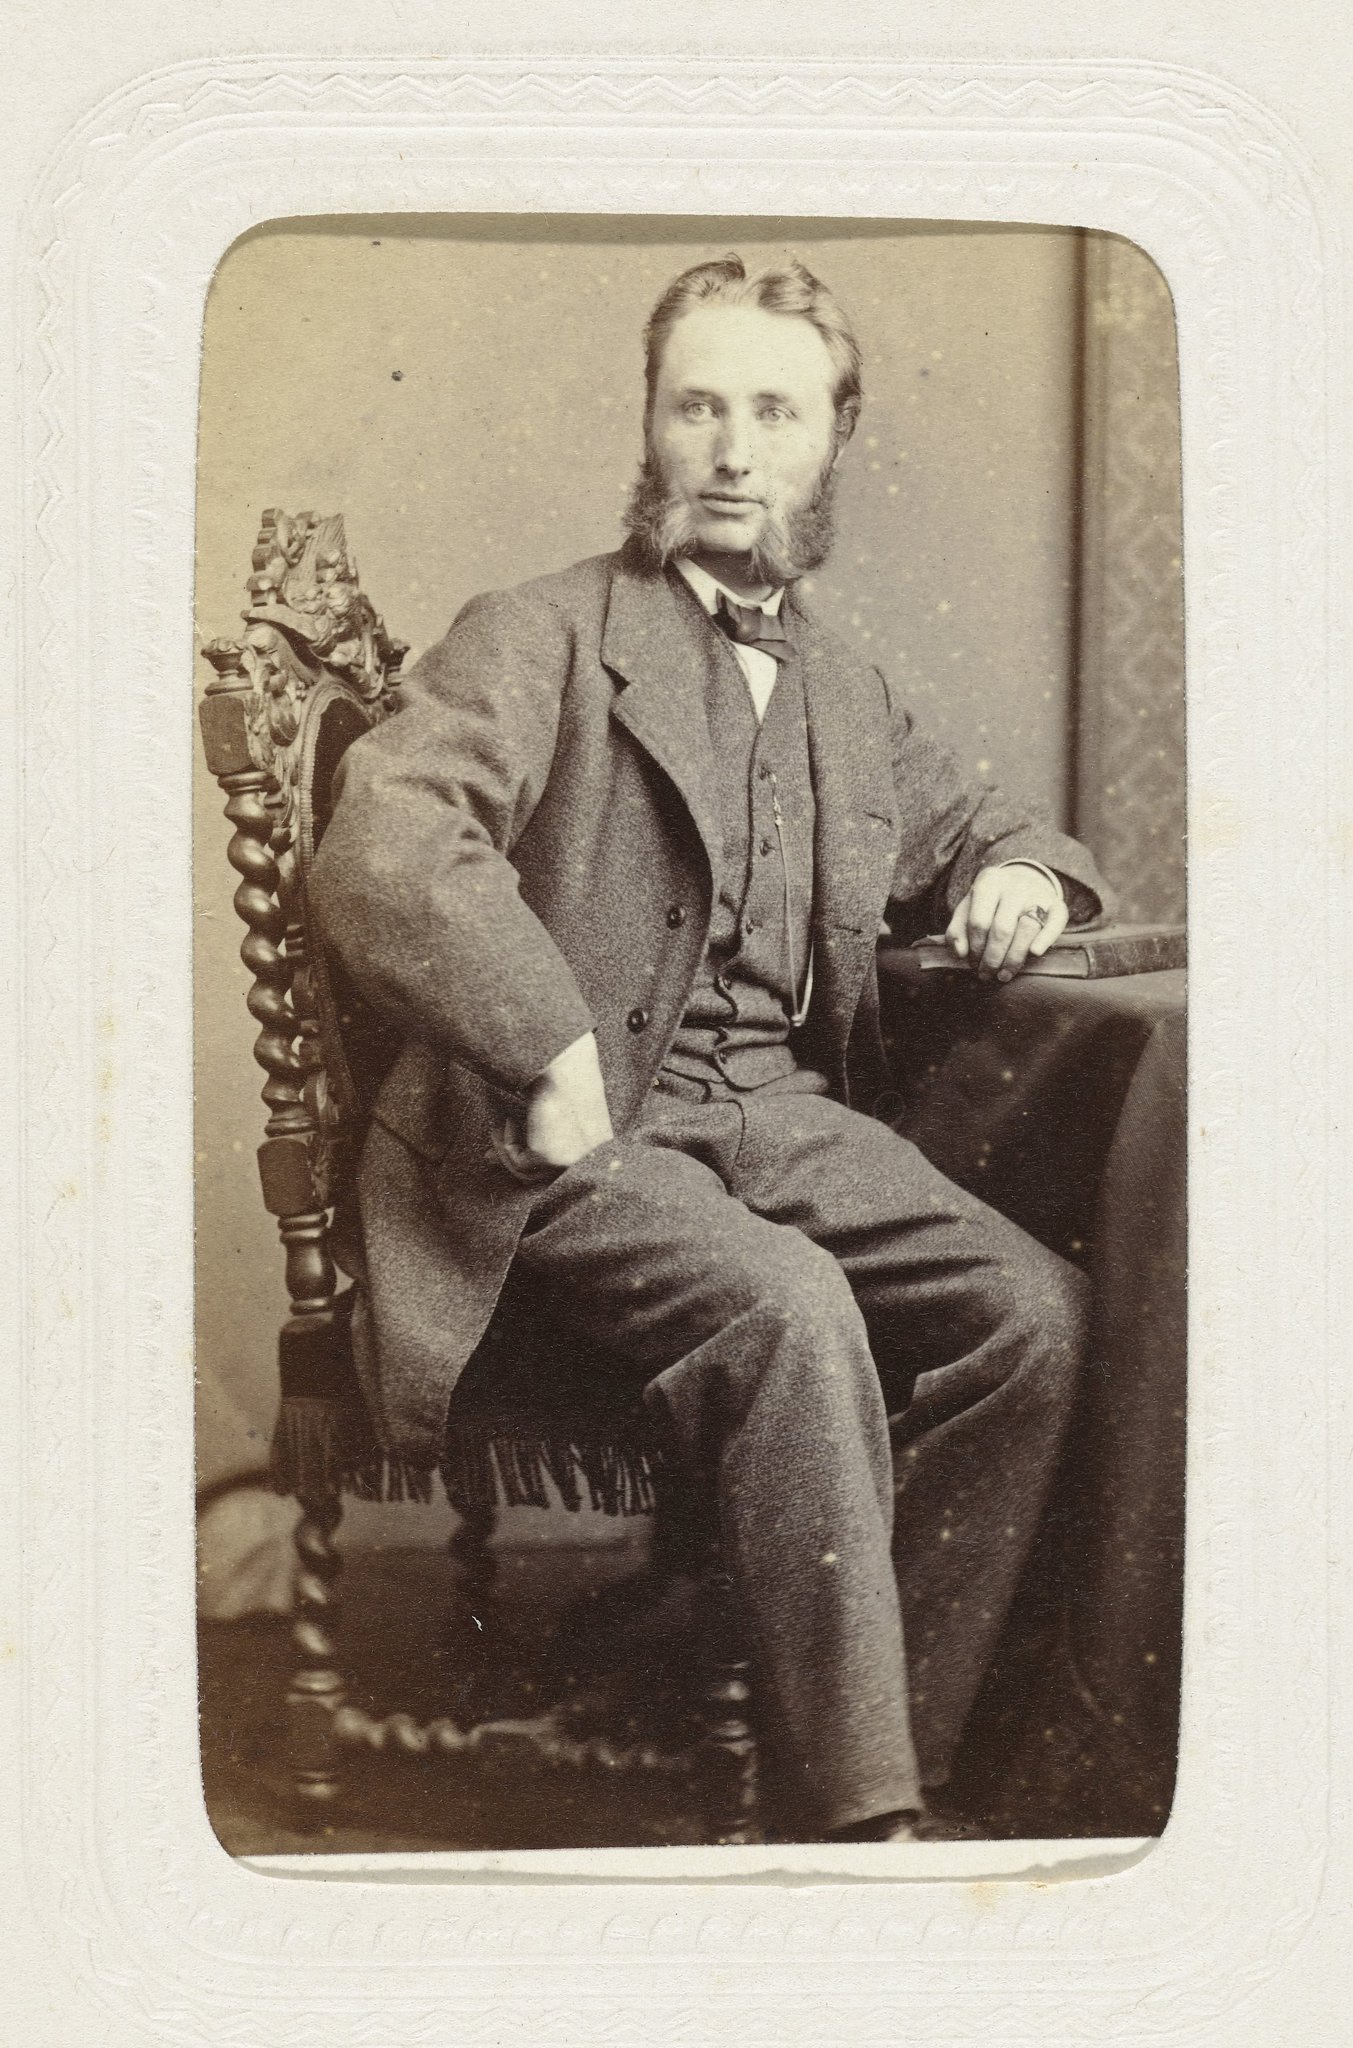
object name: carte de visite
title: Studioportret van een zittende man met grote bakkebaarden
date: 1863-1866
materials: cardboard, paper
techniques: albumen print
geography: amsterdam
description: De man zit op een stoel met gedraaide poten en leunt op tafel.